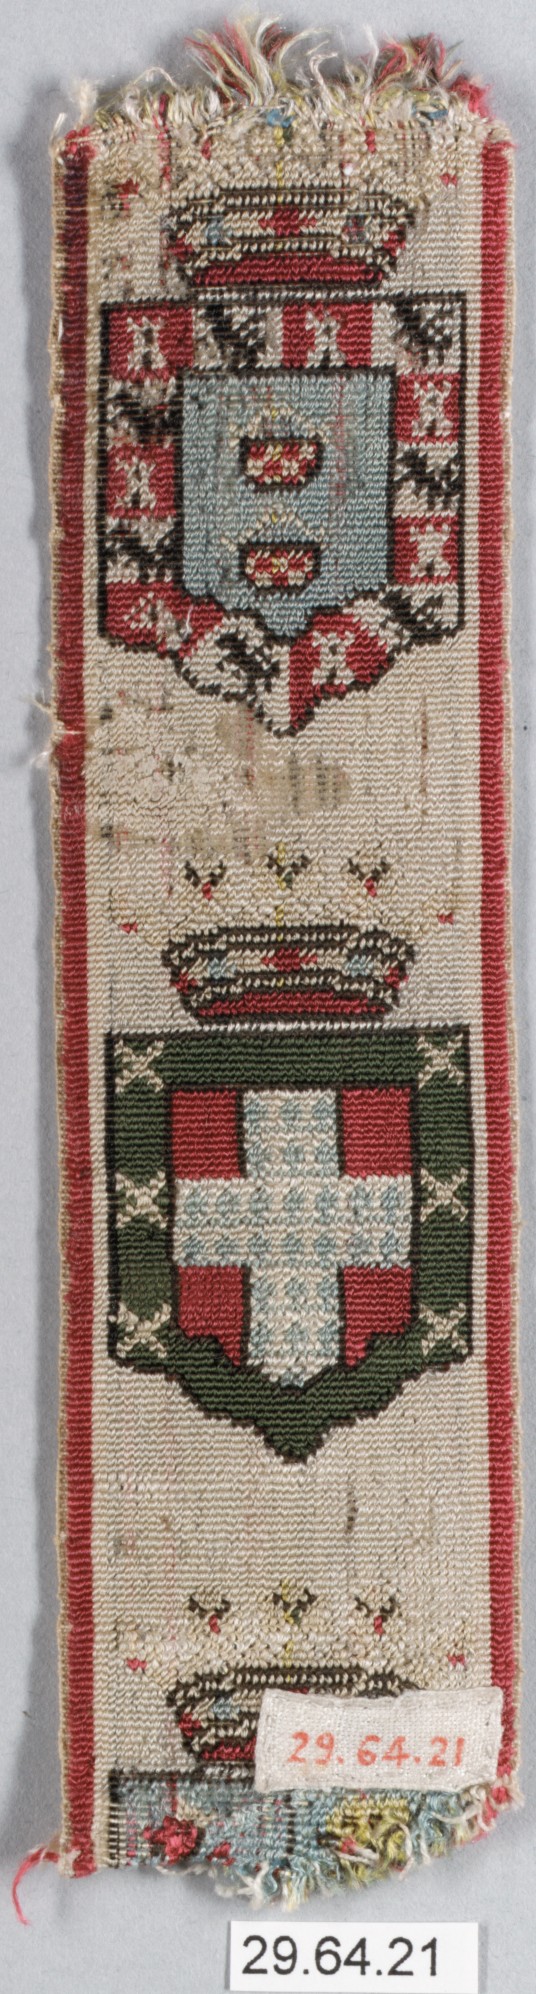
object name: galloon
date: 1701-1900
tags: coat of arms